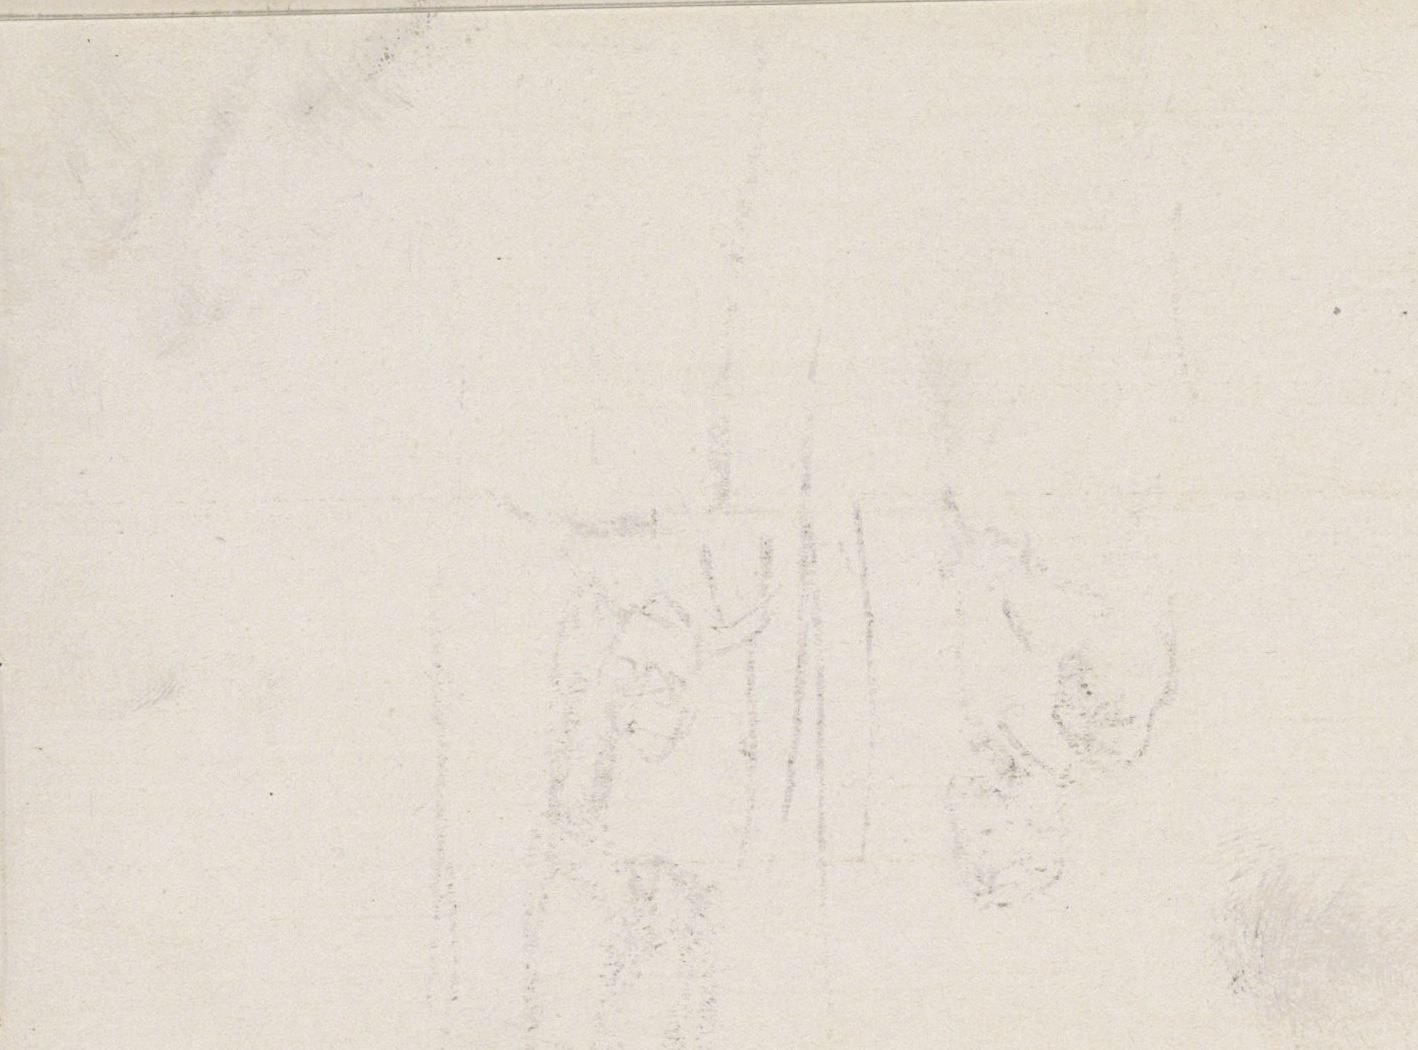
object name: sketchbook leaf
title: Abklatsch van de krijttekening op pagina 67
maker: isaac israels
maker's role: draughtsman, painter, print maker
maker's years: 1865-1934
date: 1875-1934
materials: paper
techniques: printmaking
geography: paris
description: Pagina 68 uit schetsboek XLV met 85 pagina's.